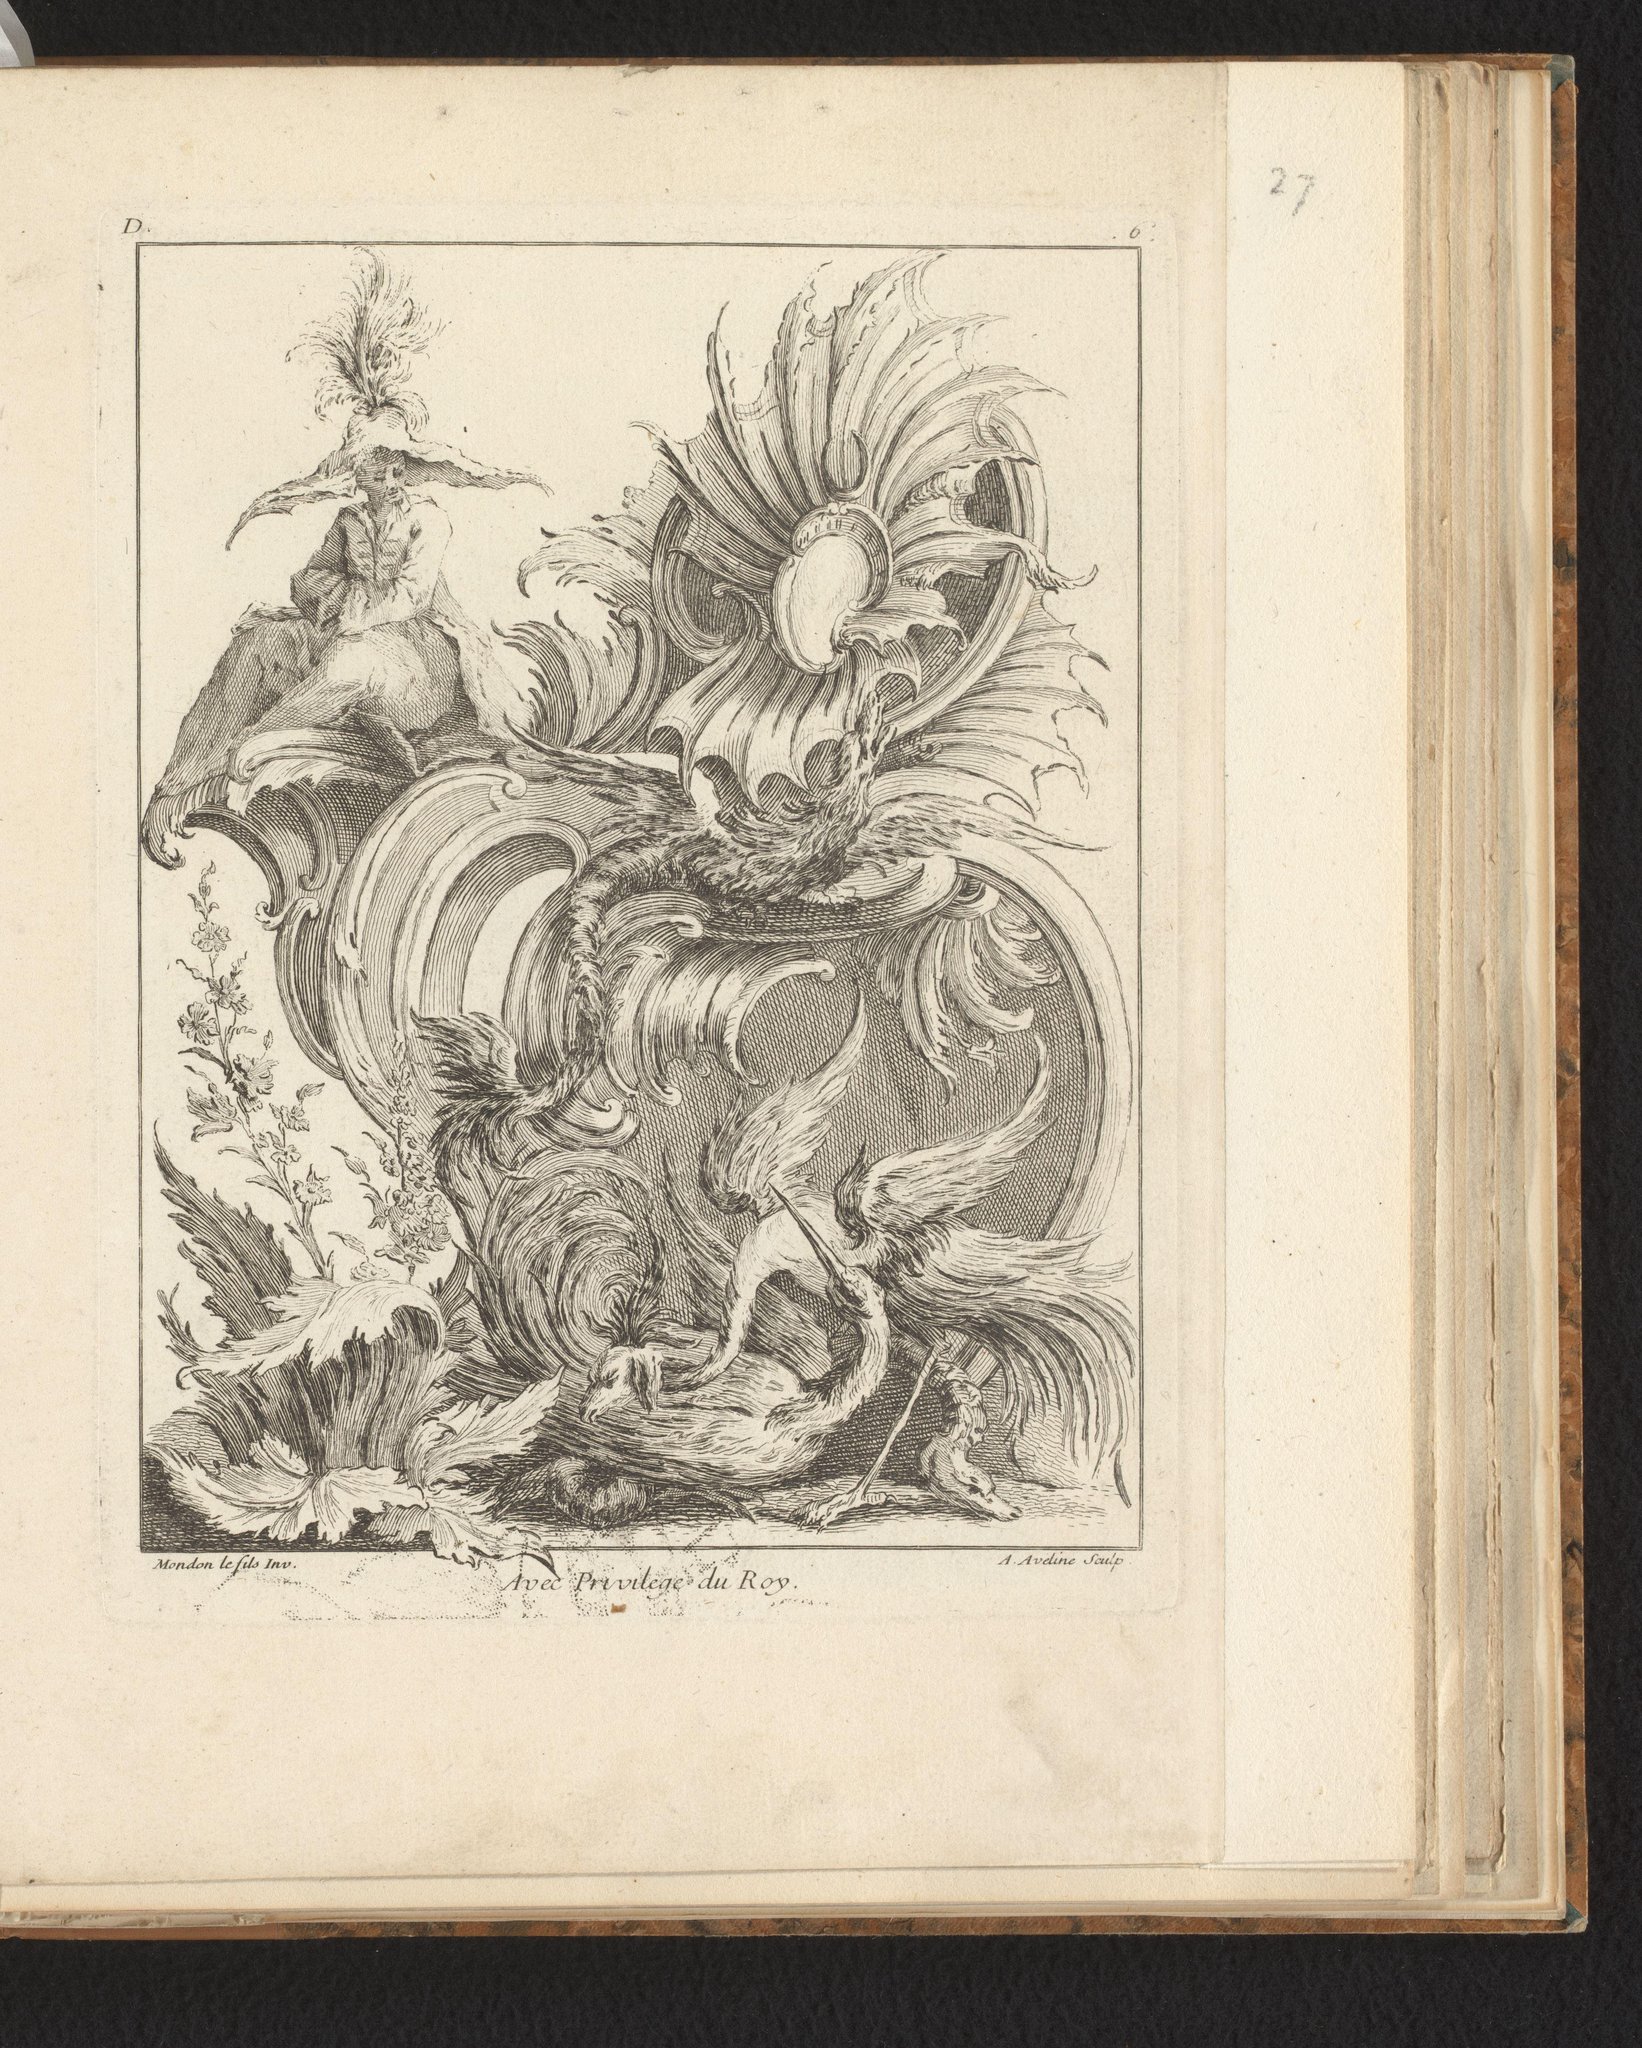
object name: album leaf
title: Quatrième Livre de Formes ornées de Rocailles (...) et Dragons Chinois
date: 1736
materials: paper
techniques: etching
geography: france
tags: rocaille ornament, fabulous animals ~ birds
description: Deze serie is linksboven genummerd met een letter D. Prent maakt deel uit van een album.